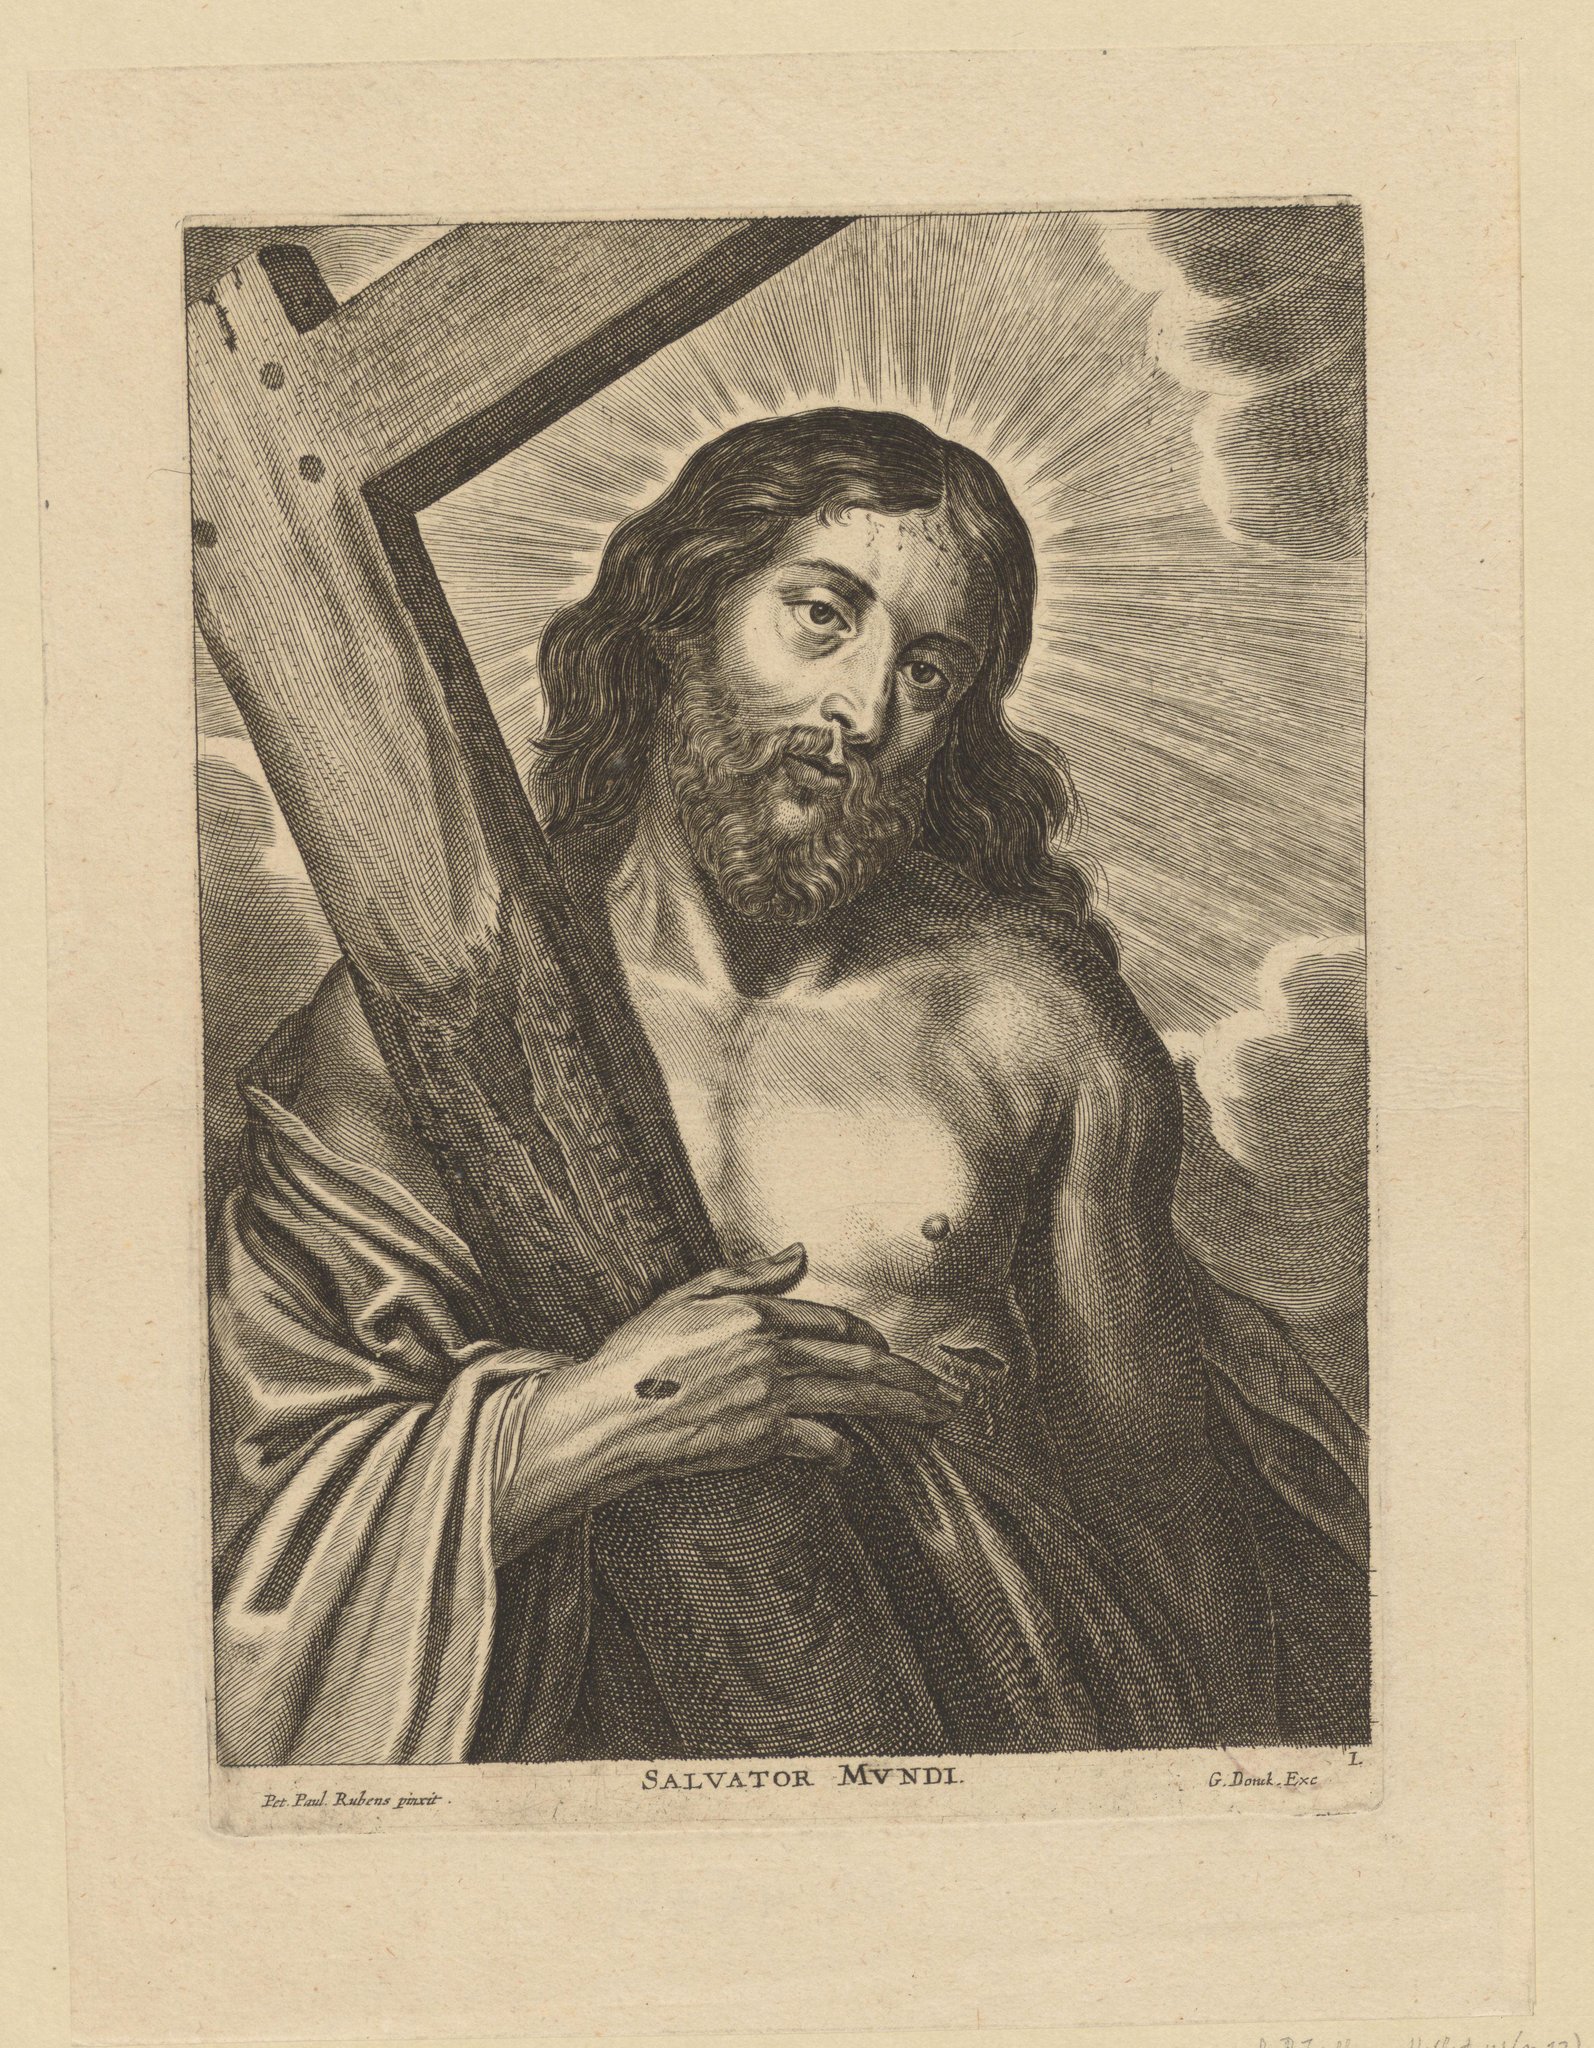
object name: print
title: Herrezen Christus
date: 1611-1612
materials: paper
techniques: engraving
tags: the risen christ (with wounds, but without crown of thorns), sometimes holding the cross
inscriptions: collector's mark: Lugt 240